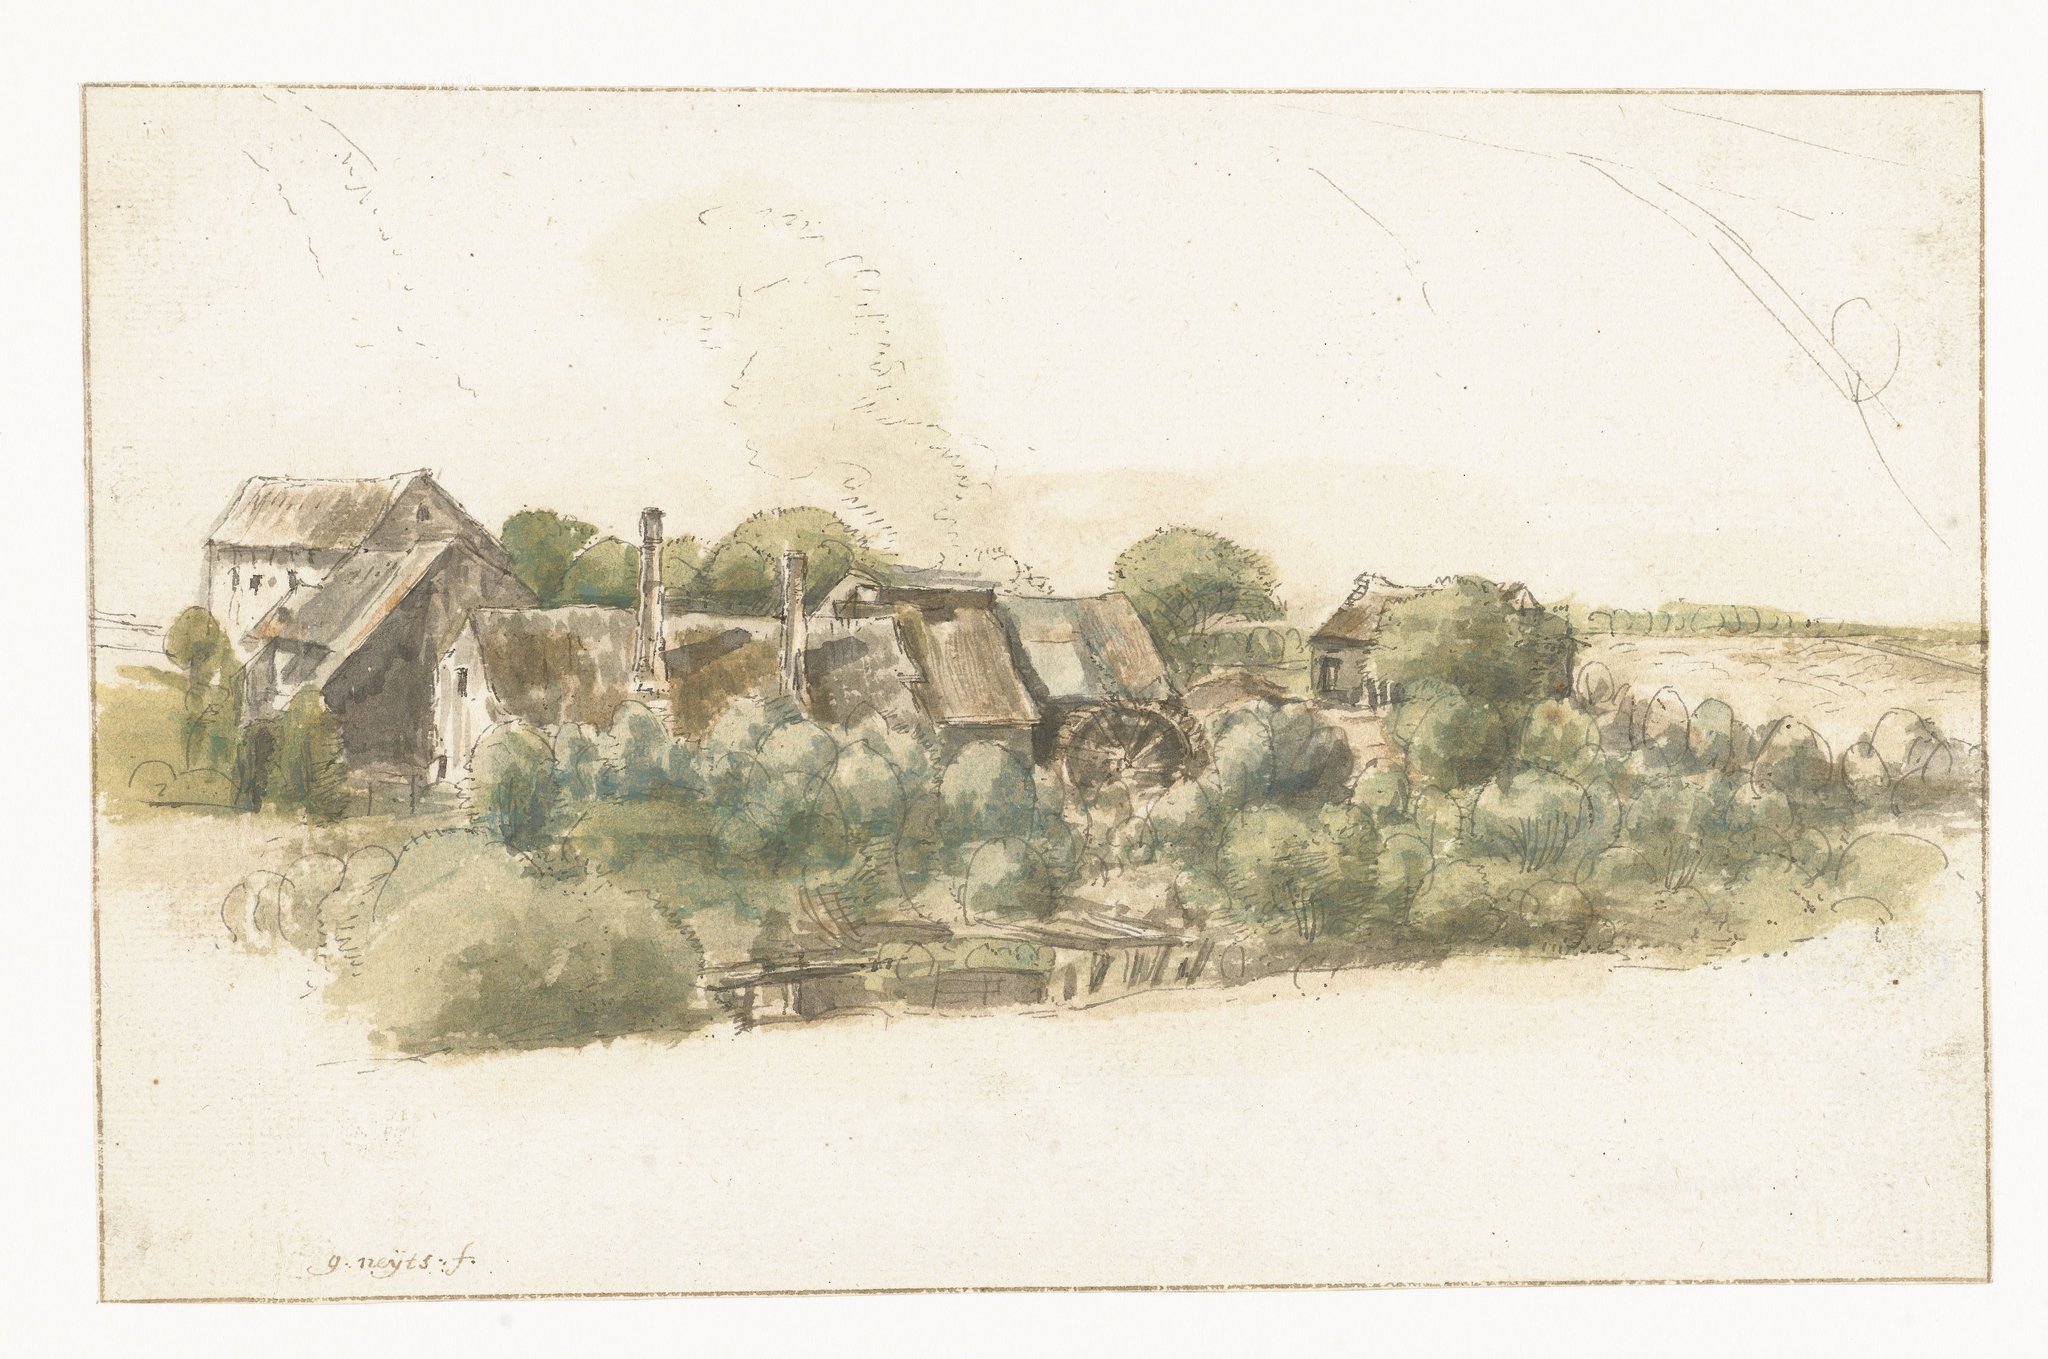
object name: watercolor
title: Gezicht op enkele huizen en een watermolen tussen bomen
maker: gilles neyts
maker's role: draughtsman, print maker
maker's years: 1623-1687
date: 1633-1687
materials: paper, watercolor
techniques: brush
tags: prospect of village, silhouette of village, watermill, watermill in landscape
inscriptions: : ‘op den Kuyer’